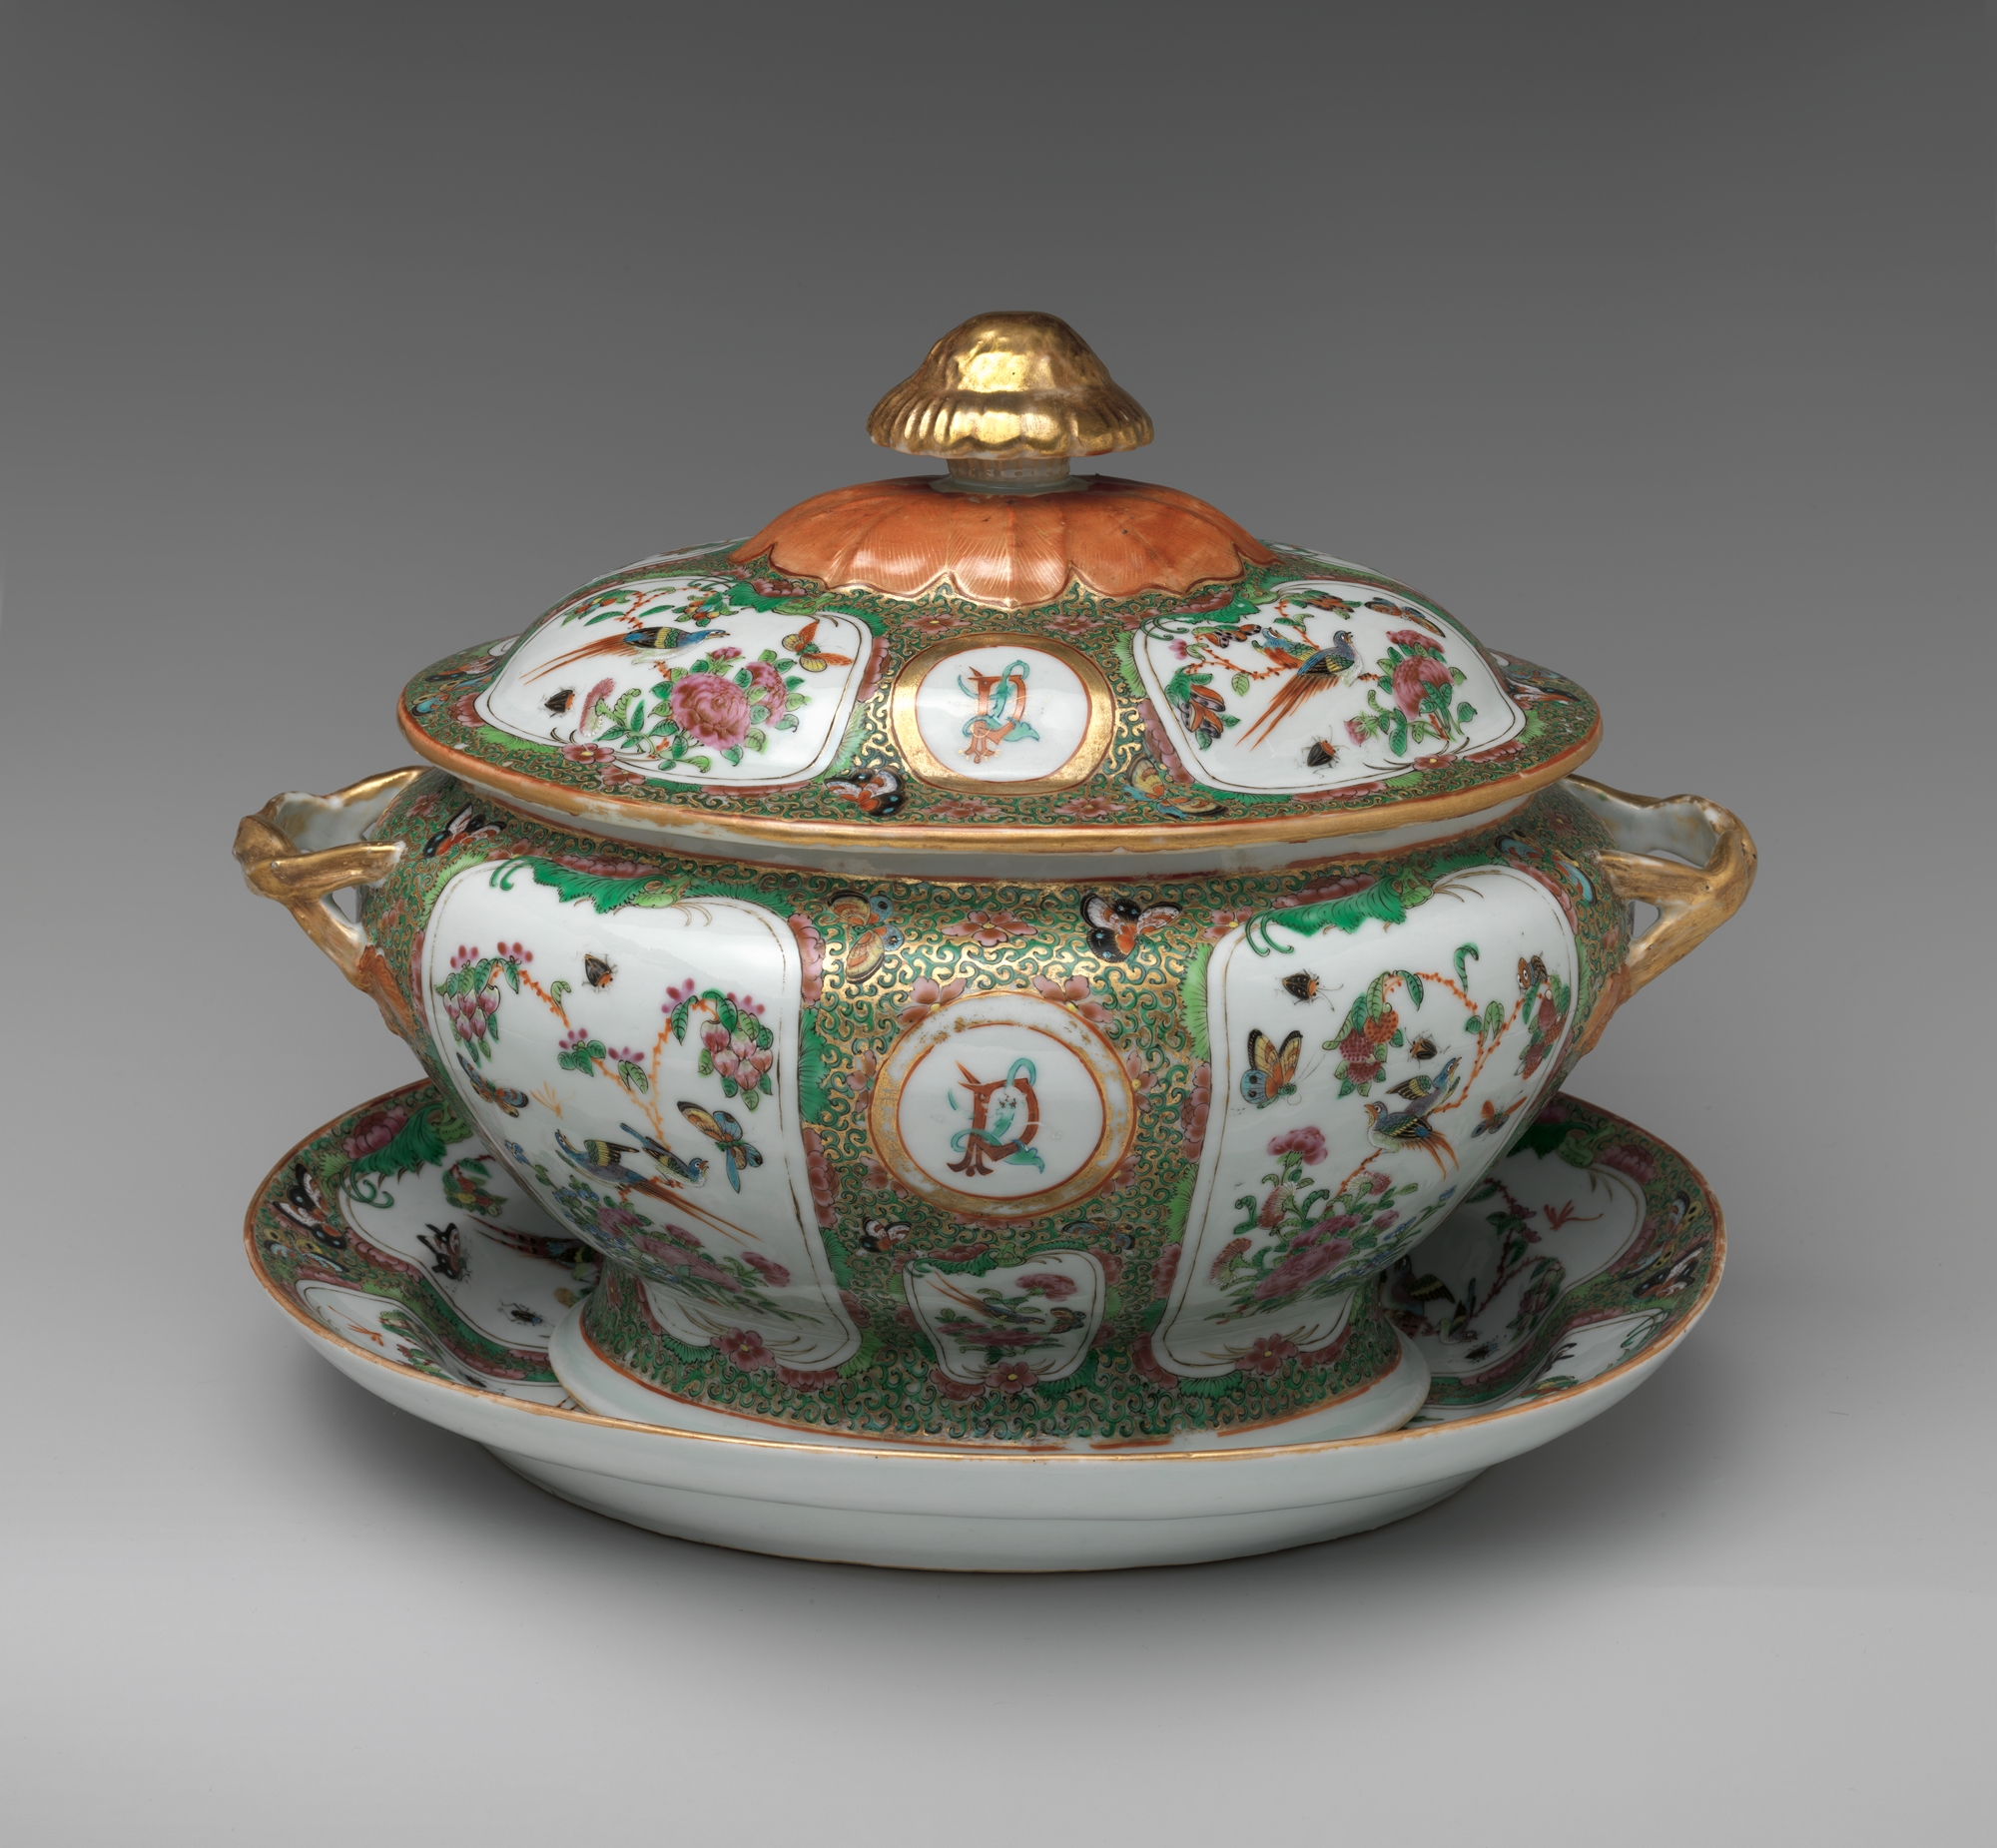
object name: tureen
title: Covered Tureen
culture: chinese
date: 1860-1866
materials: porcelain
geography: china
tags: birds,butterflies